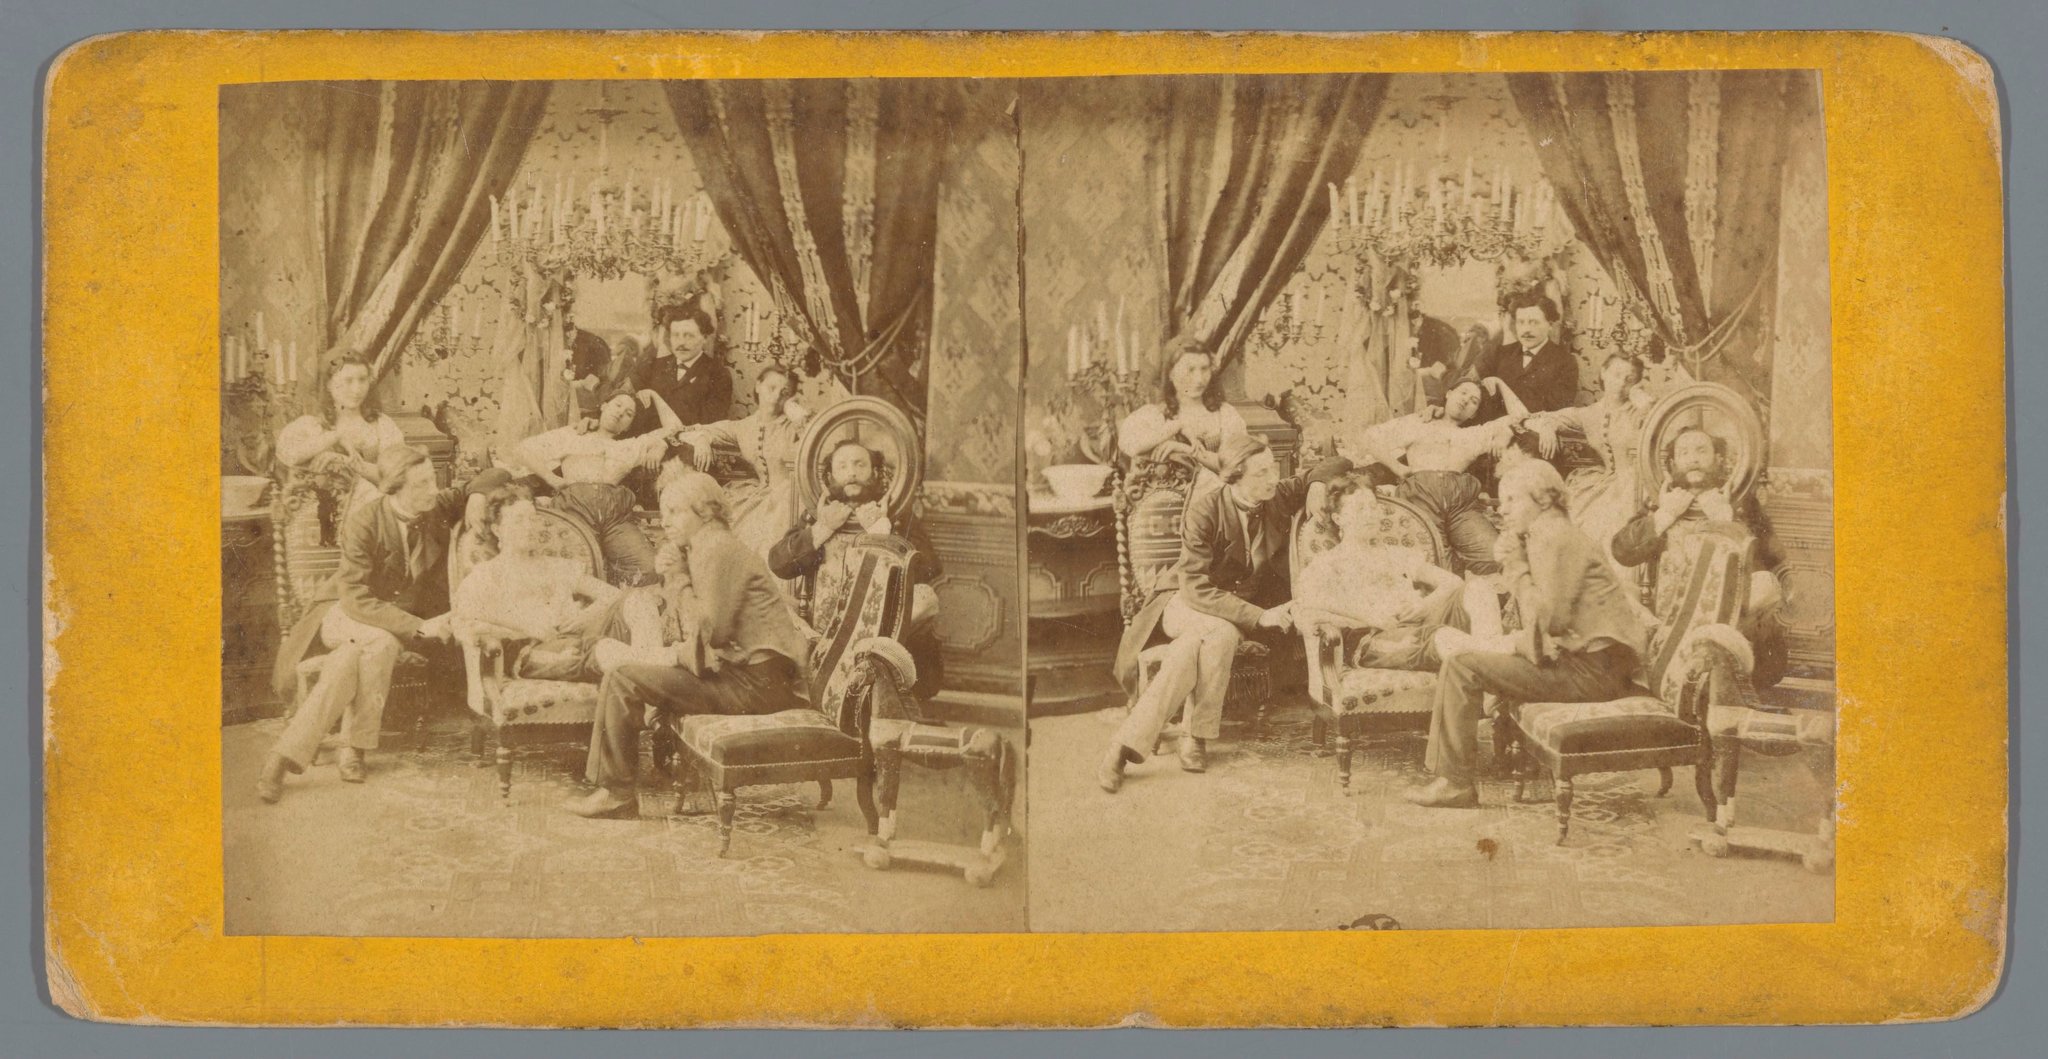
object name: stereograph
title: Gezelschap in een zitkamer, met rechts een man die door een schilderijlijst kijkt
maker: Anonymous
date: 1850-1880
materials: cardboard, photographic support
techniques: albumen print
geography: europe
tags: living-room, parlour, sitting-room, europe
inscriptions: number: ‘20’